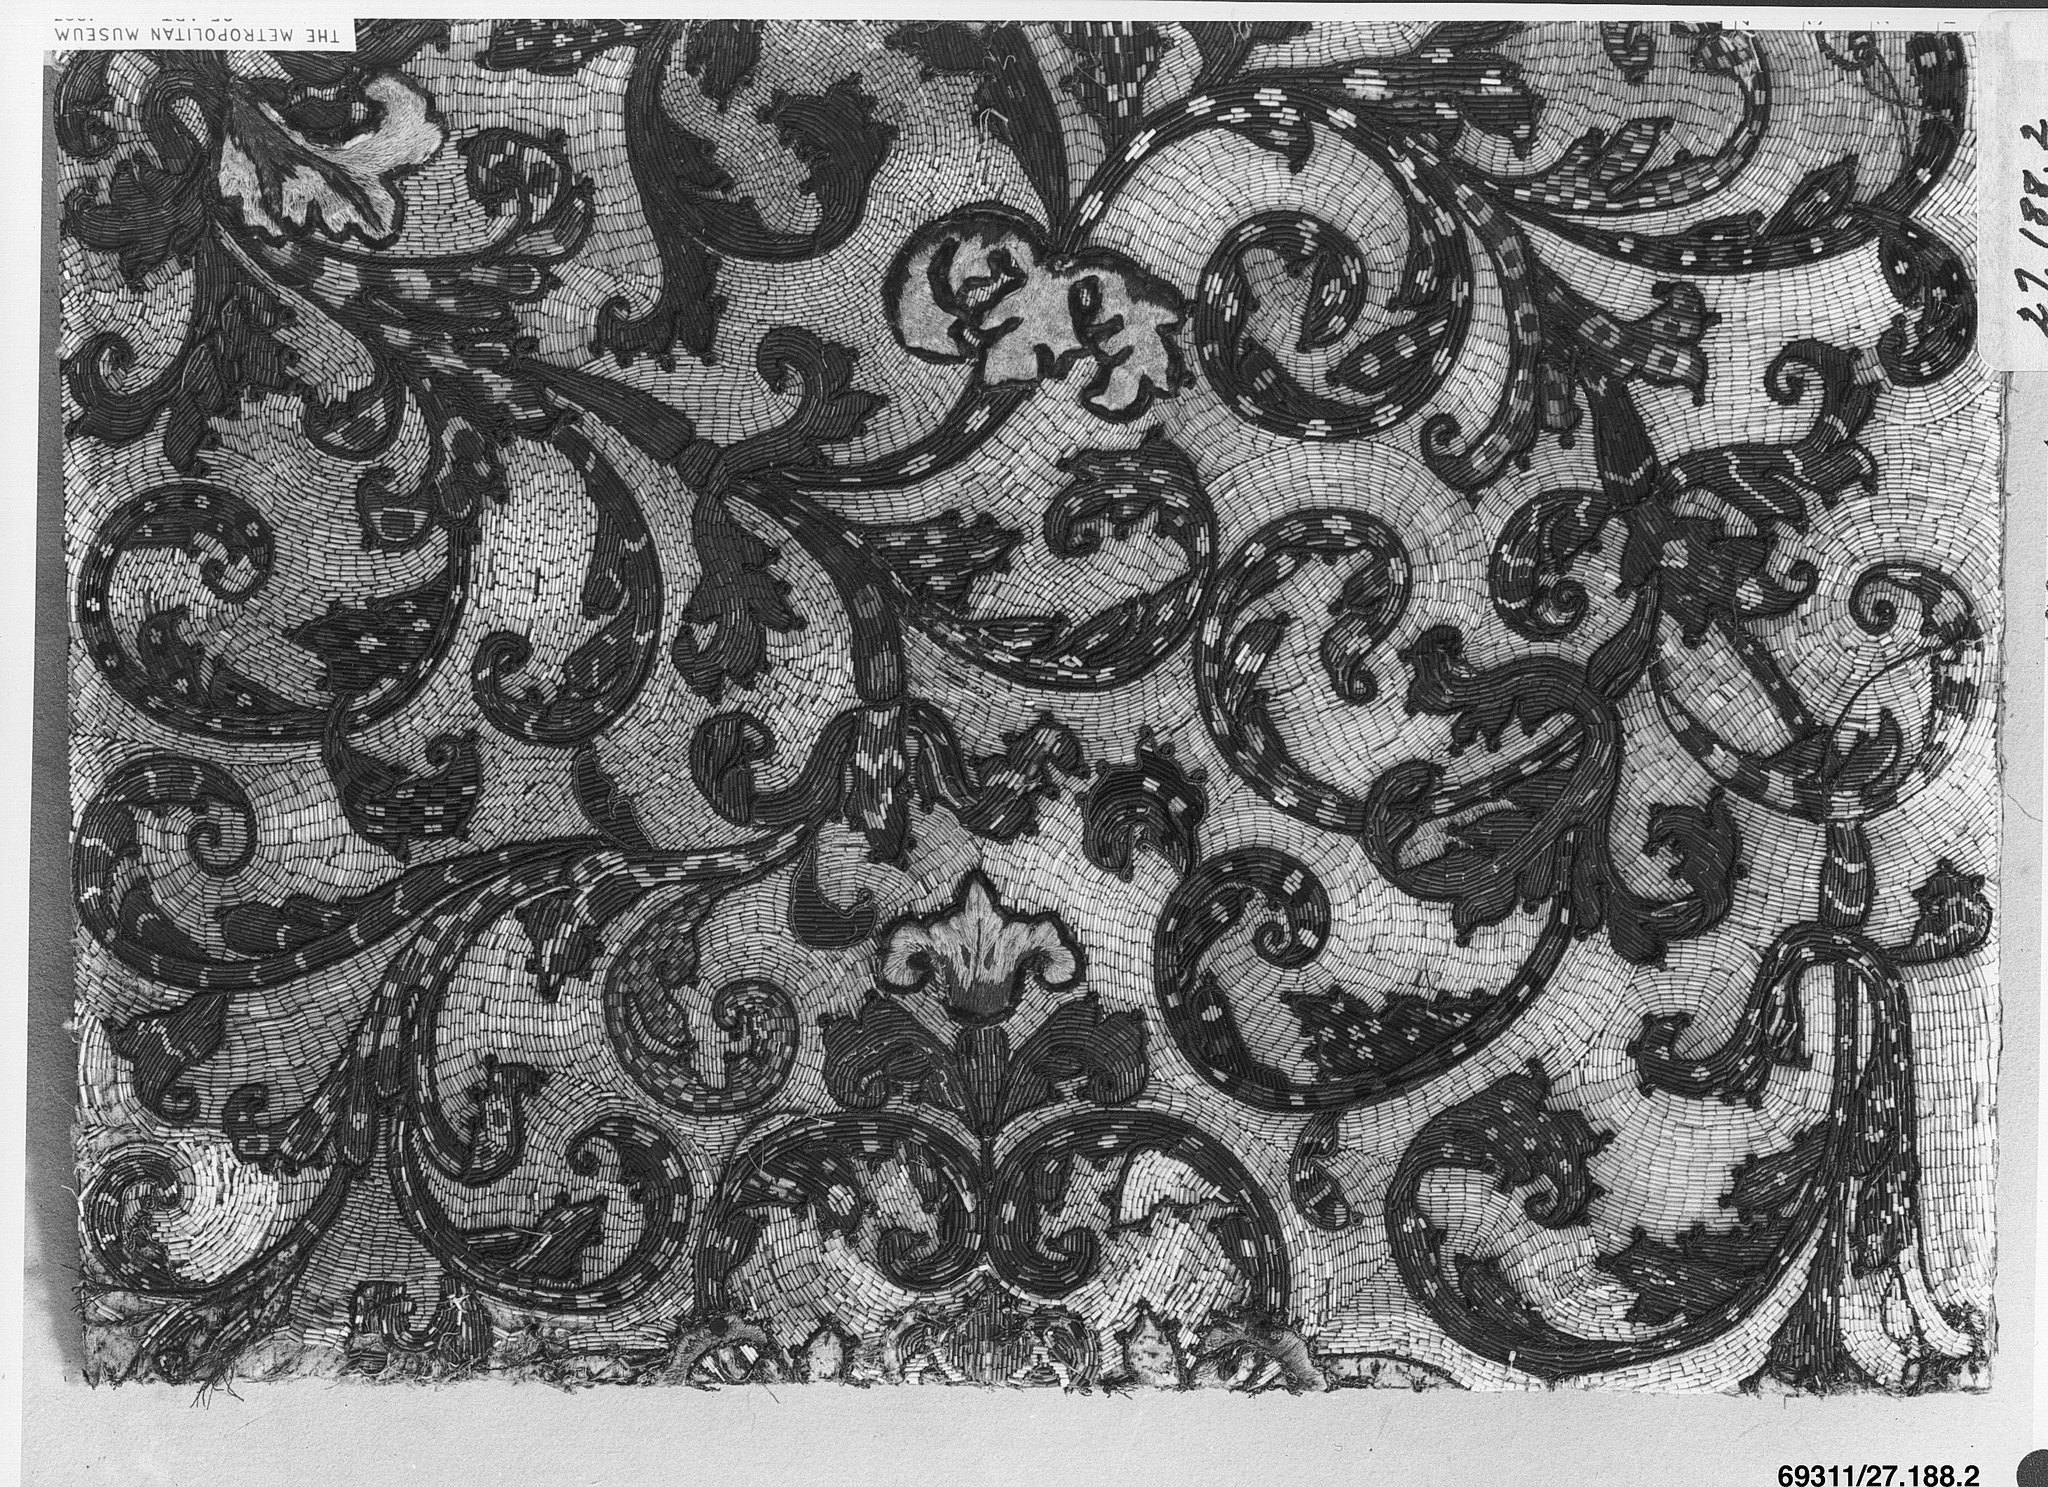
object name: altar frontal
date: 1601-1700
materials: linen, silk